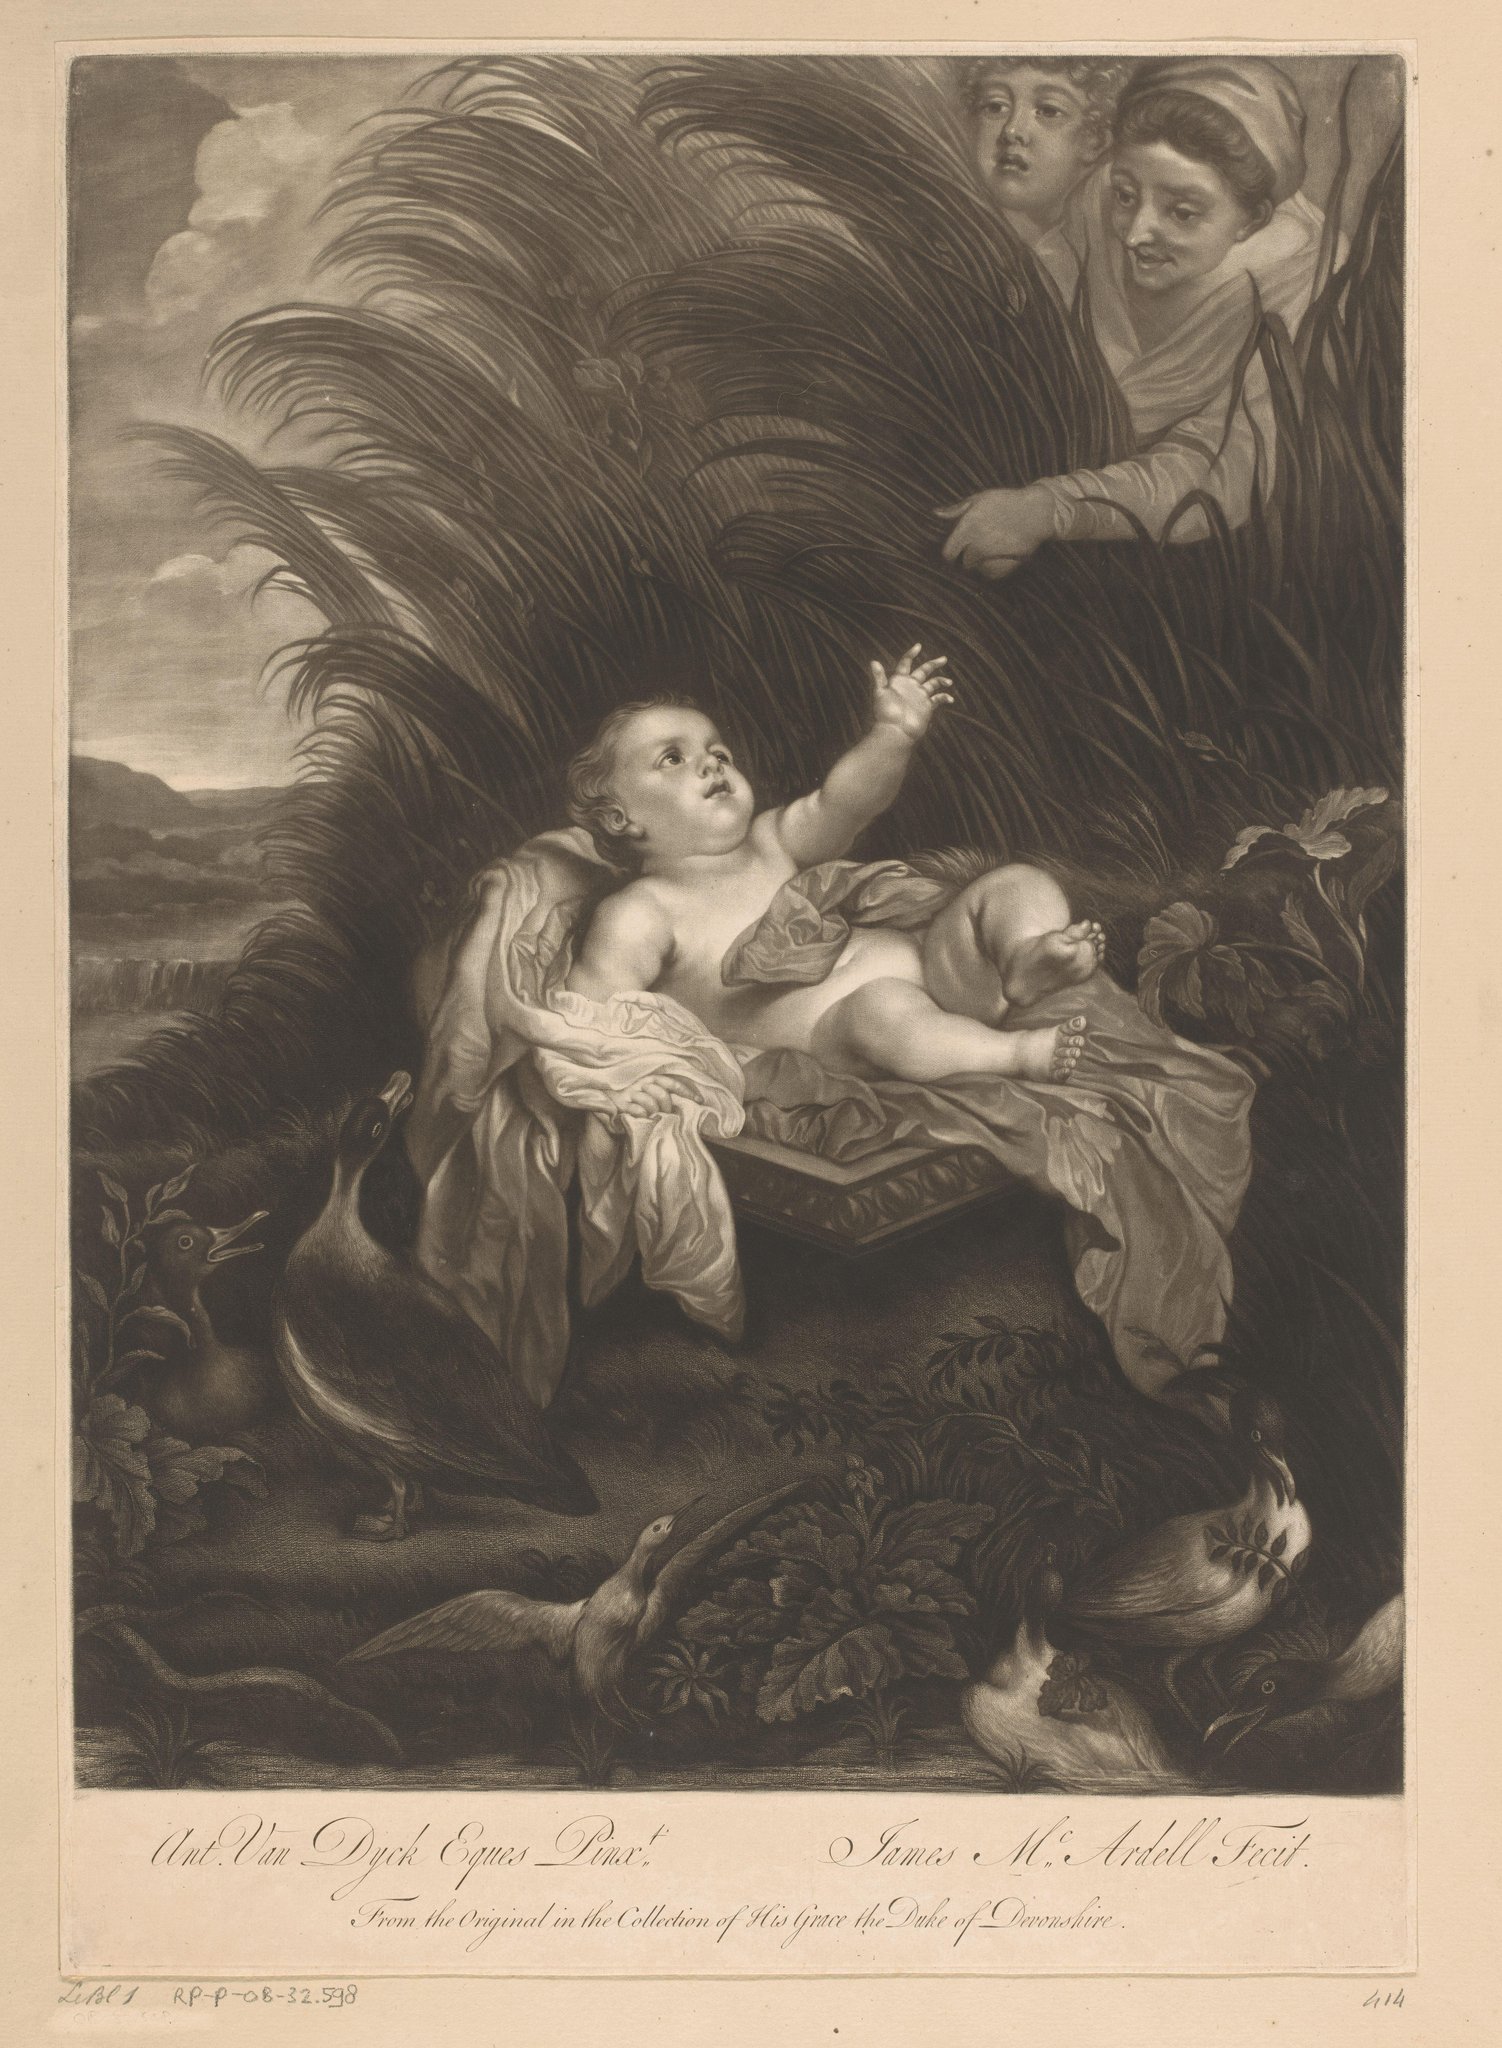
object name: print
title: Vinden van Mozes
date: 1745-1765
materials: paper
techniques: mezzotint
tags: the finding of moses: pharaoh's daughter comes to bathe with her maidens in the river and discovers the child floating on the water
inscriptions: collector's mark: Lugt 240